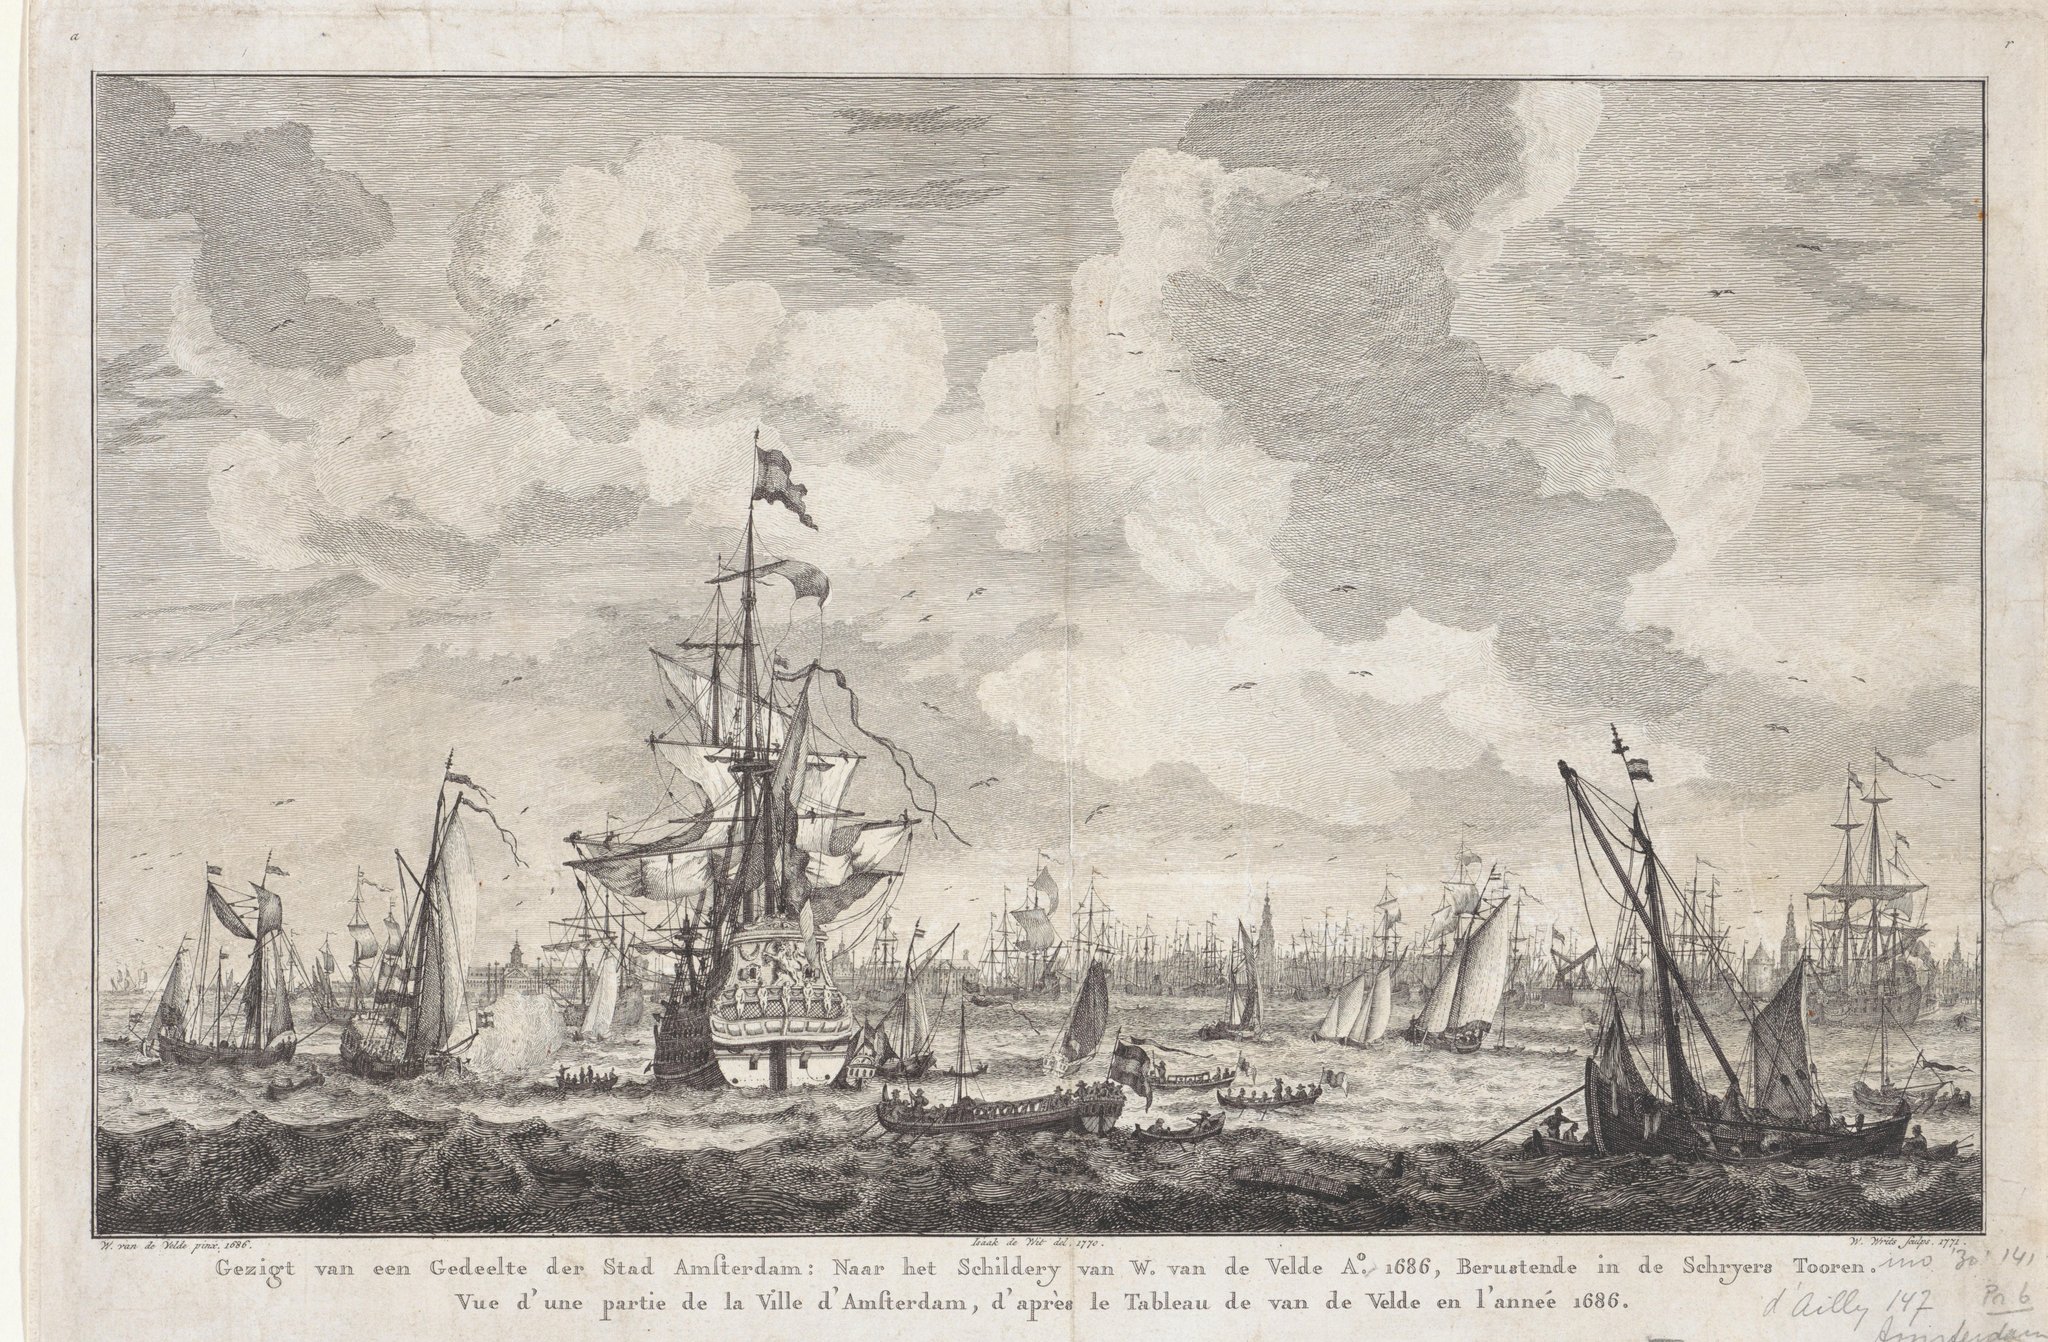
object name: print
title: Schepen op het IJ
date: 1771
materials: paper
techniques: etching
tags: sailing-ship, sailing-boat, rowing-boat, canoe, etc.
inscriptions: collector's mark: Lugt 2228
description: Schepen op het IJ, met op de achtergrond een profiel van de oostzijde van Amsterdam. Op de achtergrond van links naar rechts: de VOC-pakhuizen op Oostenburg, de Oosterkerk, 's-Lands Zeemagazijn, de Montelbaanstoren, de Scheepskranen, de Schreierstoren en Oudekerkstoren.